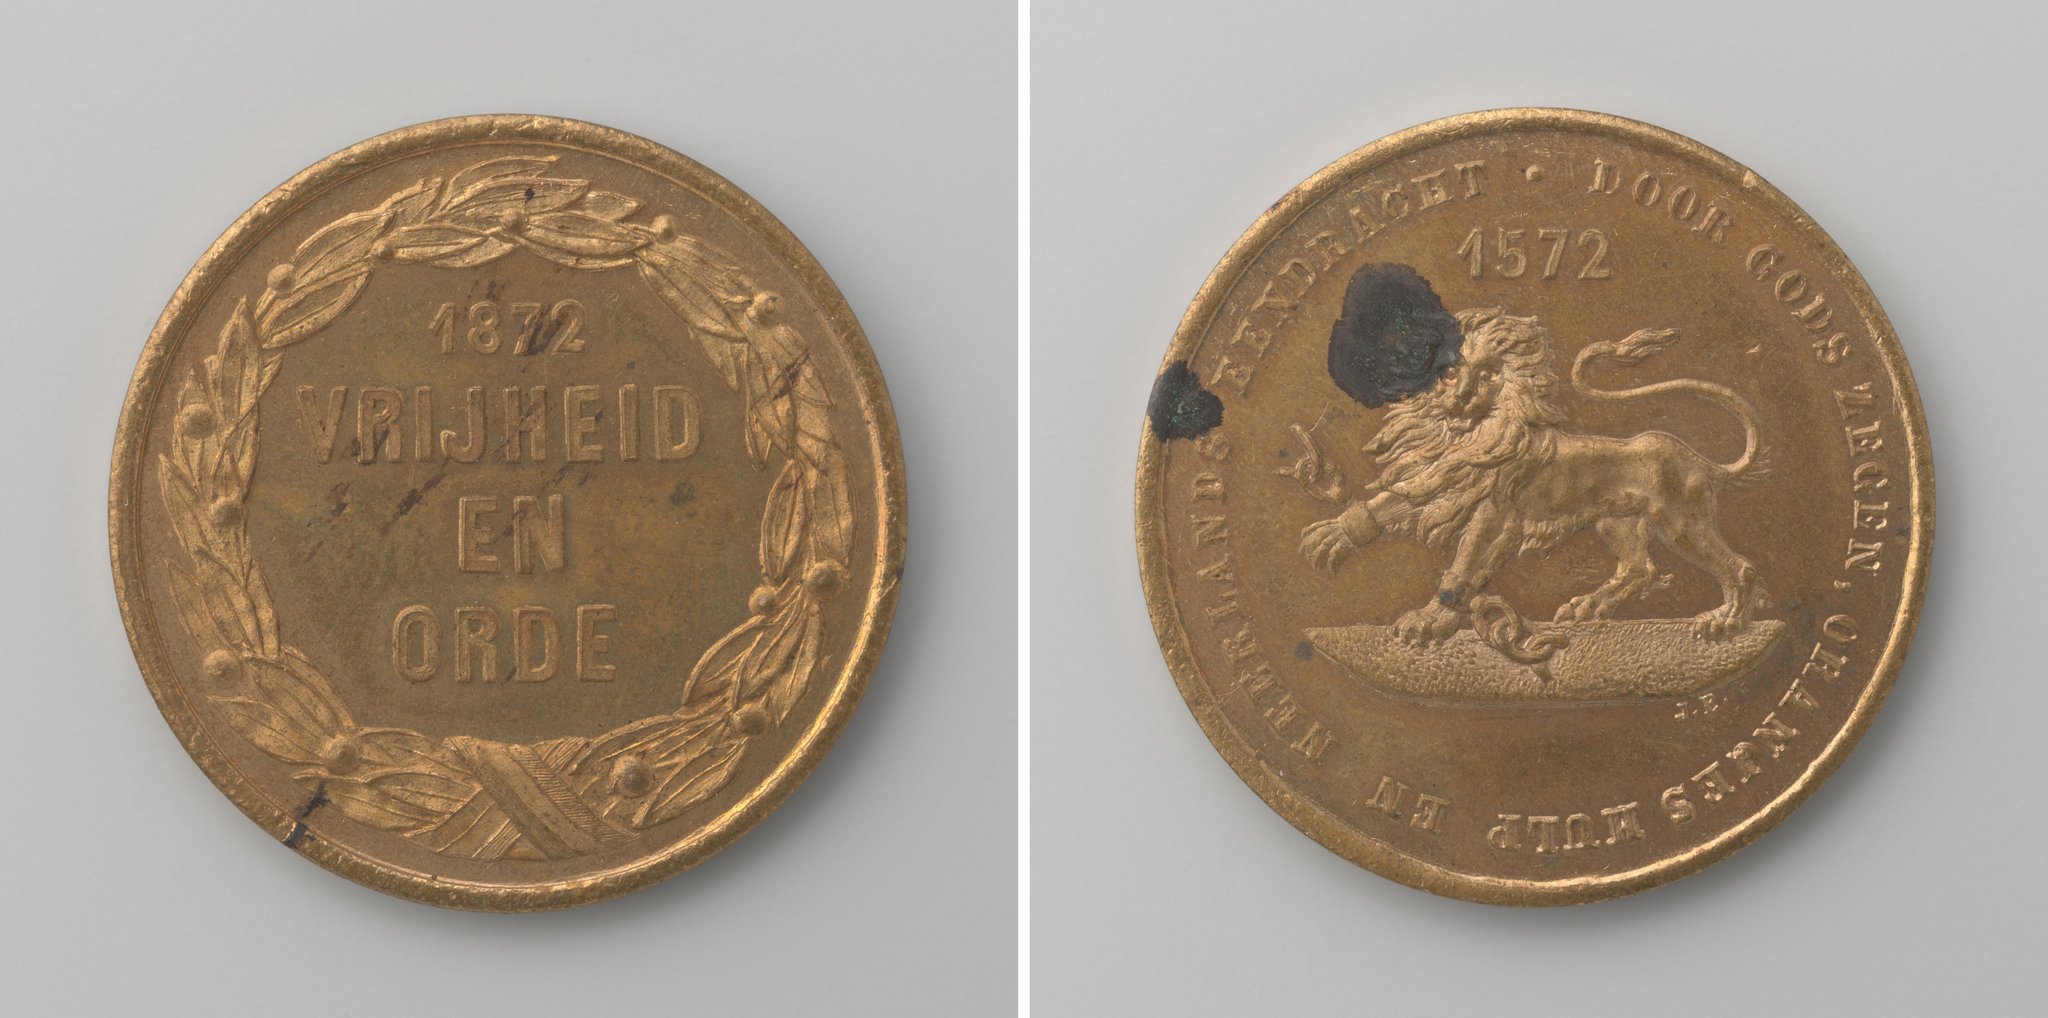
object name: history medal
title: Herdenking van de inname van Den Briel 1872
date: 1872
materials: brass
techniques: striking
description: Messing penning, op de voorzijde de Nederlandse Leeuw met verbroken kluisters onder het jaartal 1572, met omschrift, op de keerzijde vier regels tekst in een lauwerkrans.